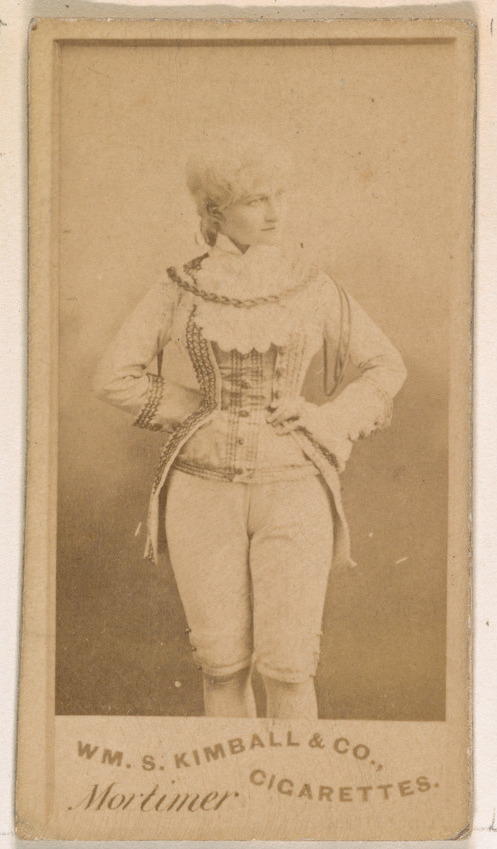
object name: photograph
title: Miss Mortimer, from the Actresses series (N203) issued by Wm. S. Kimball & Co.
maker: william s. kimball & company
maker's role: publisher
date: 1889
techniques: color lithograph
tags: portraits,women,actresses